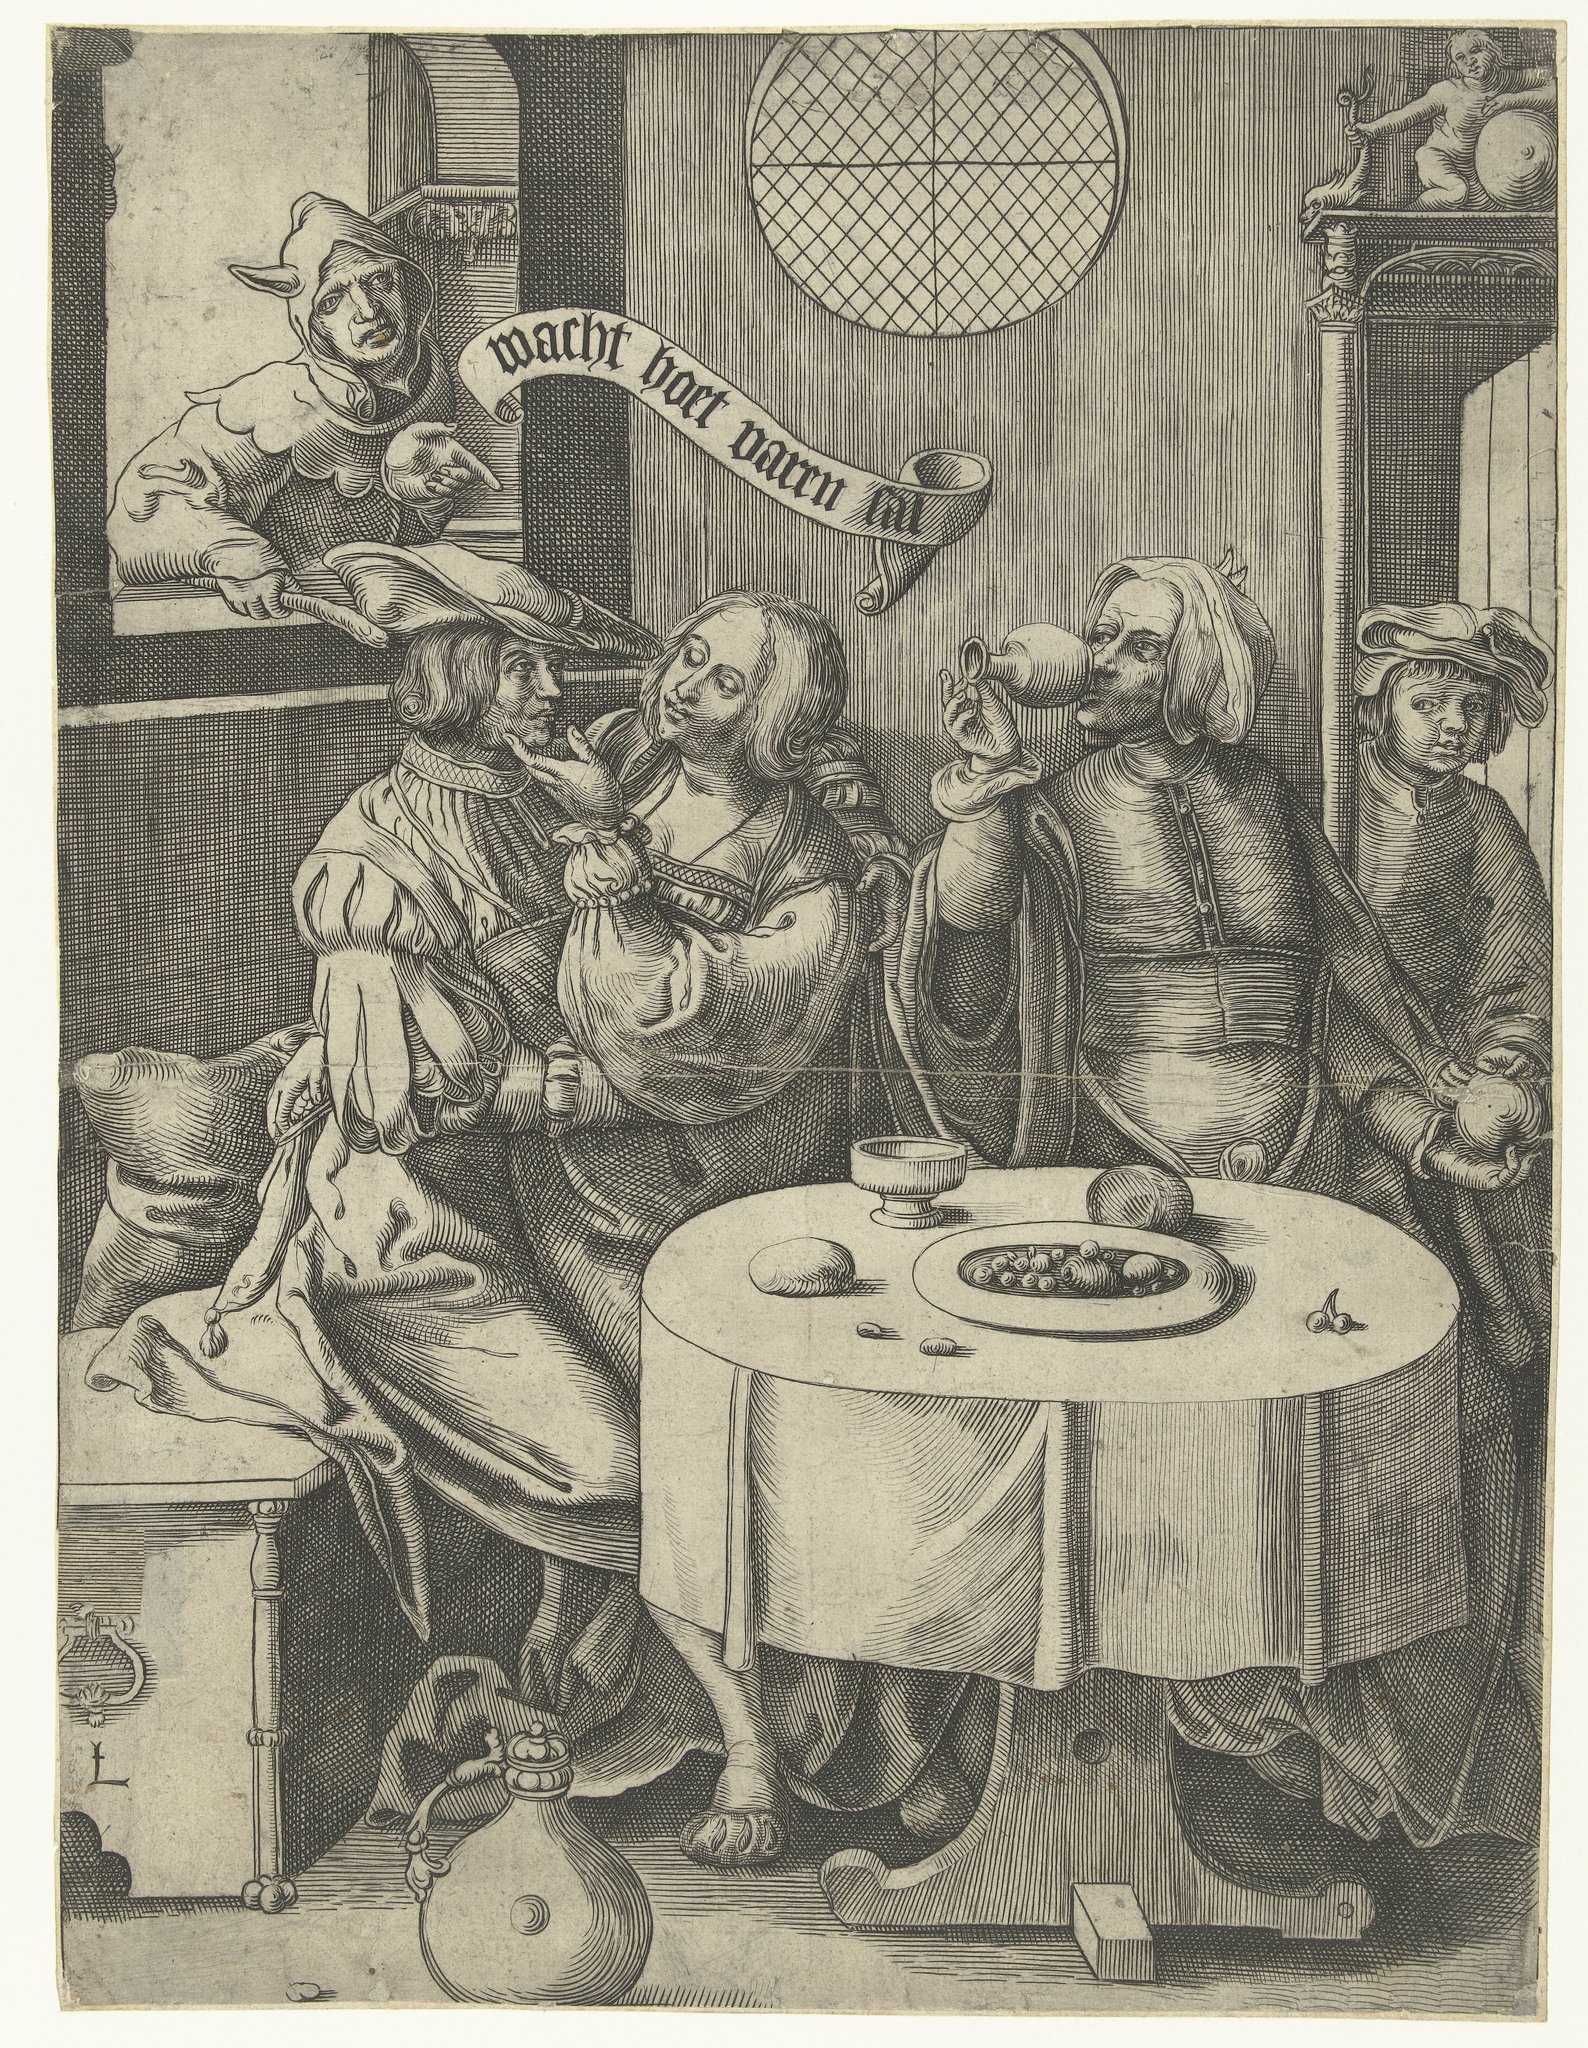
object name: print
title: De verloren zoon bij de hoeren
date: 1512-1583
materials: paper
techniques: engraving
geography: low countries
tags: the prodigal son in the midst of prostitutes feasting and dissipating his patrimony, usually in a brothel or inn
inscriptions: collector's mark: Lugt 240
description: Herberginterieur waarin een jongeman (de verloren zoon) aan een ronde tafel zit met twee vrouwen. De jonge vrouw haalt hem met één hand aan, terwijl ze met de andere hand geld uit zijn beurs pakt. De oude vrouw brengt met haar rechterhand een glas naar de mond, in de linker houdt ze een vrucht (?) die wordt gepakt door een jongen in de deuropening. Door het venster kijkt een nar toe en spreekt de woorden (op banderol): " wacht hoet varen sal".